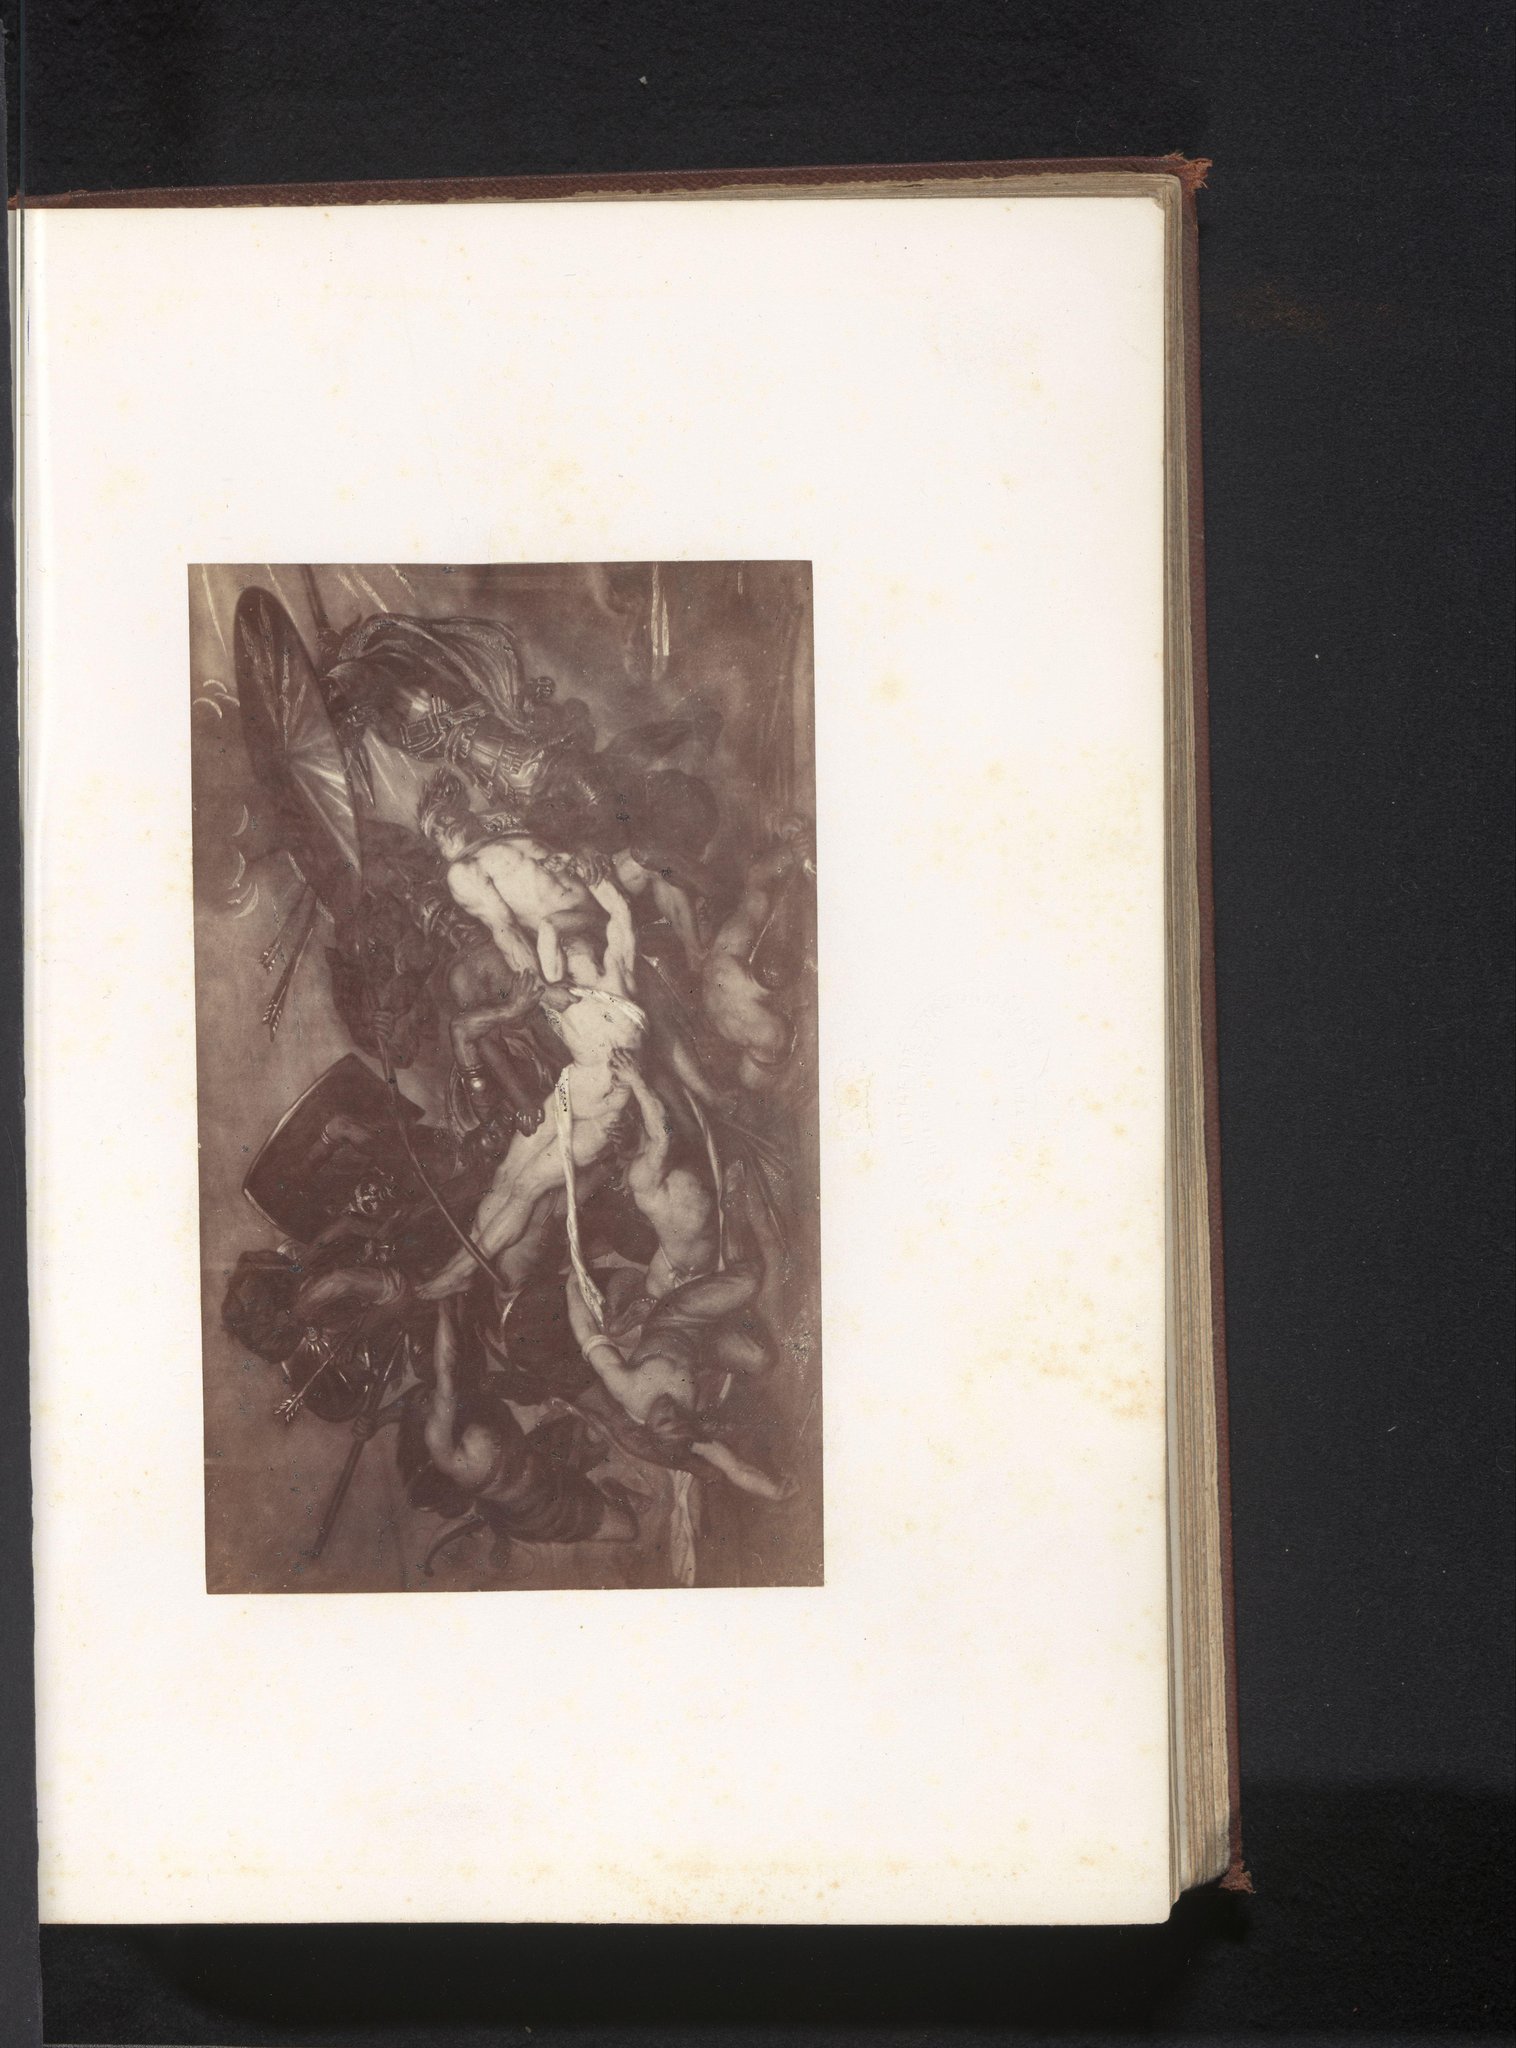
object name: page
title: Fotoreproductie van De Grieken en Trojanen vechten om het lijk van Patroclus door Antoine Wiertz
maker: edmond fierlants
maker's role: fotograaf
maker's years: 1819-1869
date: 1863-1868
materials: photographic support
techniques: albumen print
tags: the fight over the body of patroclus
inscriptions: check stamp: ‘SOCIÉTÉ ROYALE BELGE DE PHOTOGRAPHIE/ 69, RUE KEYENVELD/ BRUXELLES’